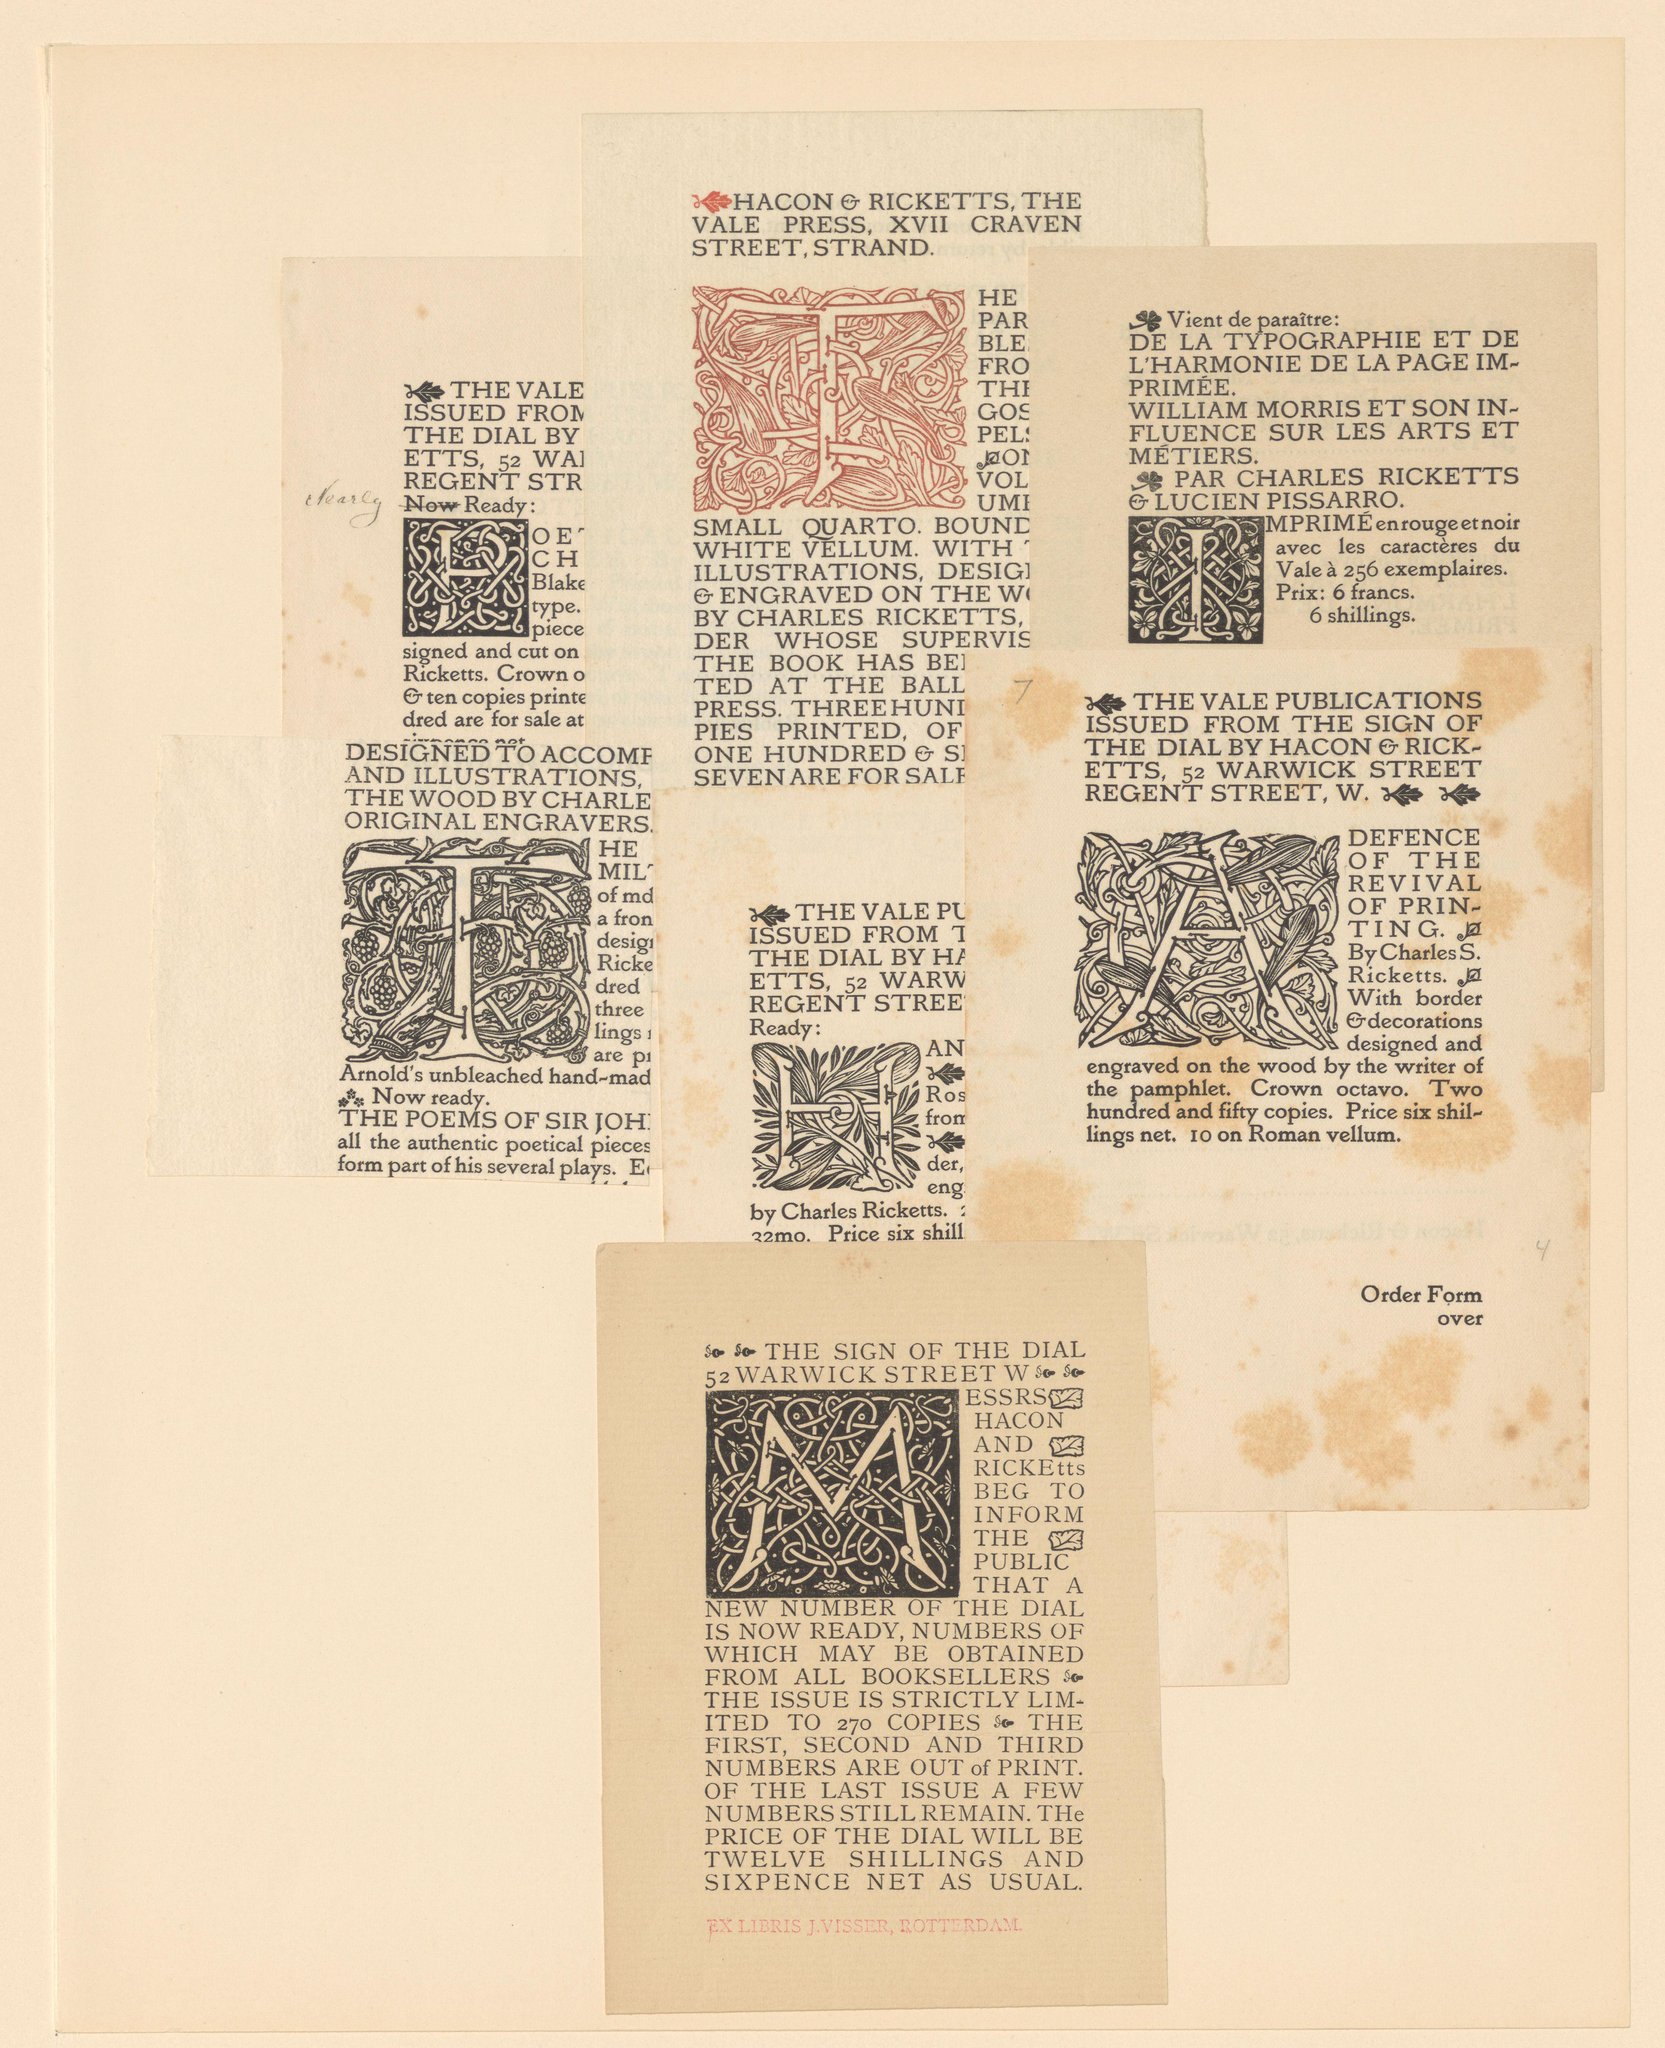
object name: advertisement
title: Tekstblad met initiaal A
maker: charles ricketts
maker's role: print maker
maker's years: 1866-1931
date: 1899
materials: paper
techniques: letterpress printing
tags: initial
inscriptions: mark: ‘Ex libris J. Visser, Rotterdam’, collector's mark: Lugt 2228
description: Deze prent is een advertentie met bestelformulier voor het werk 'A defence of the revival of printing' van Charles Ricketts.